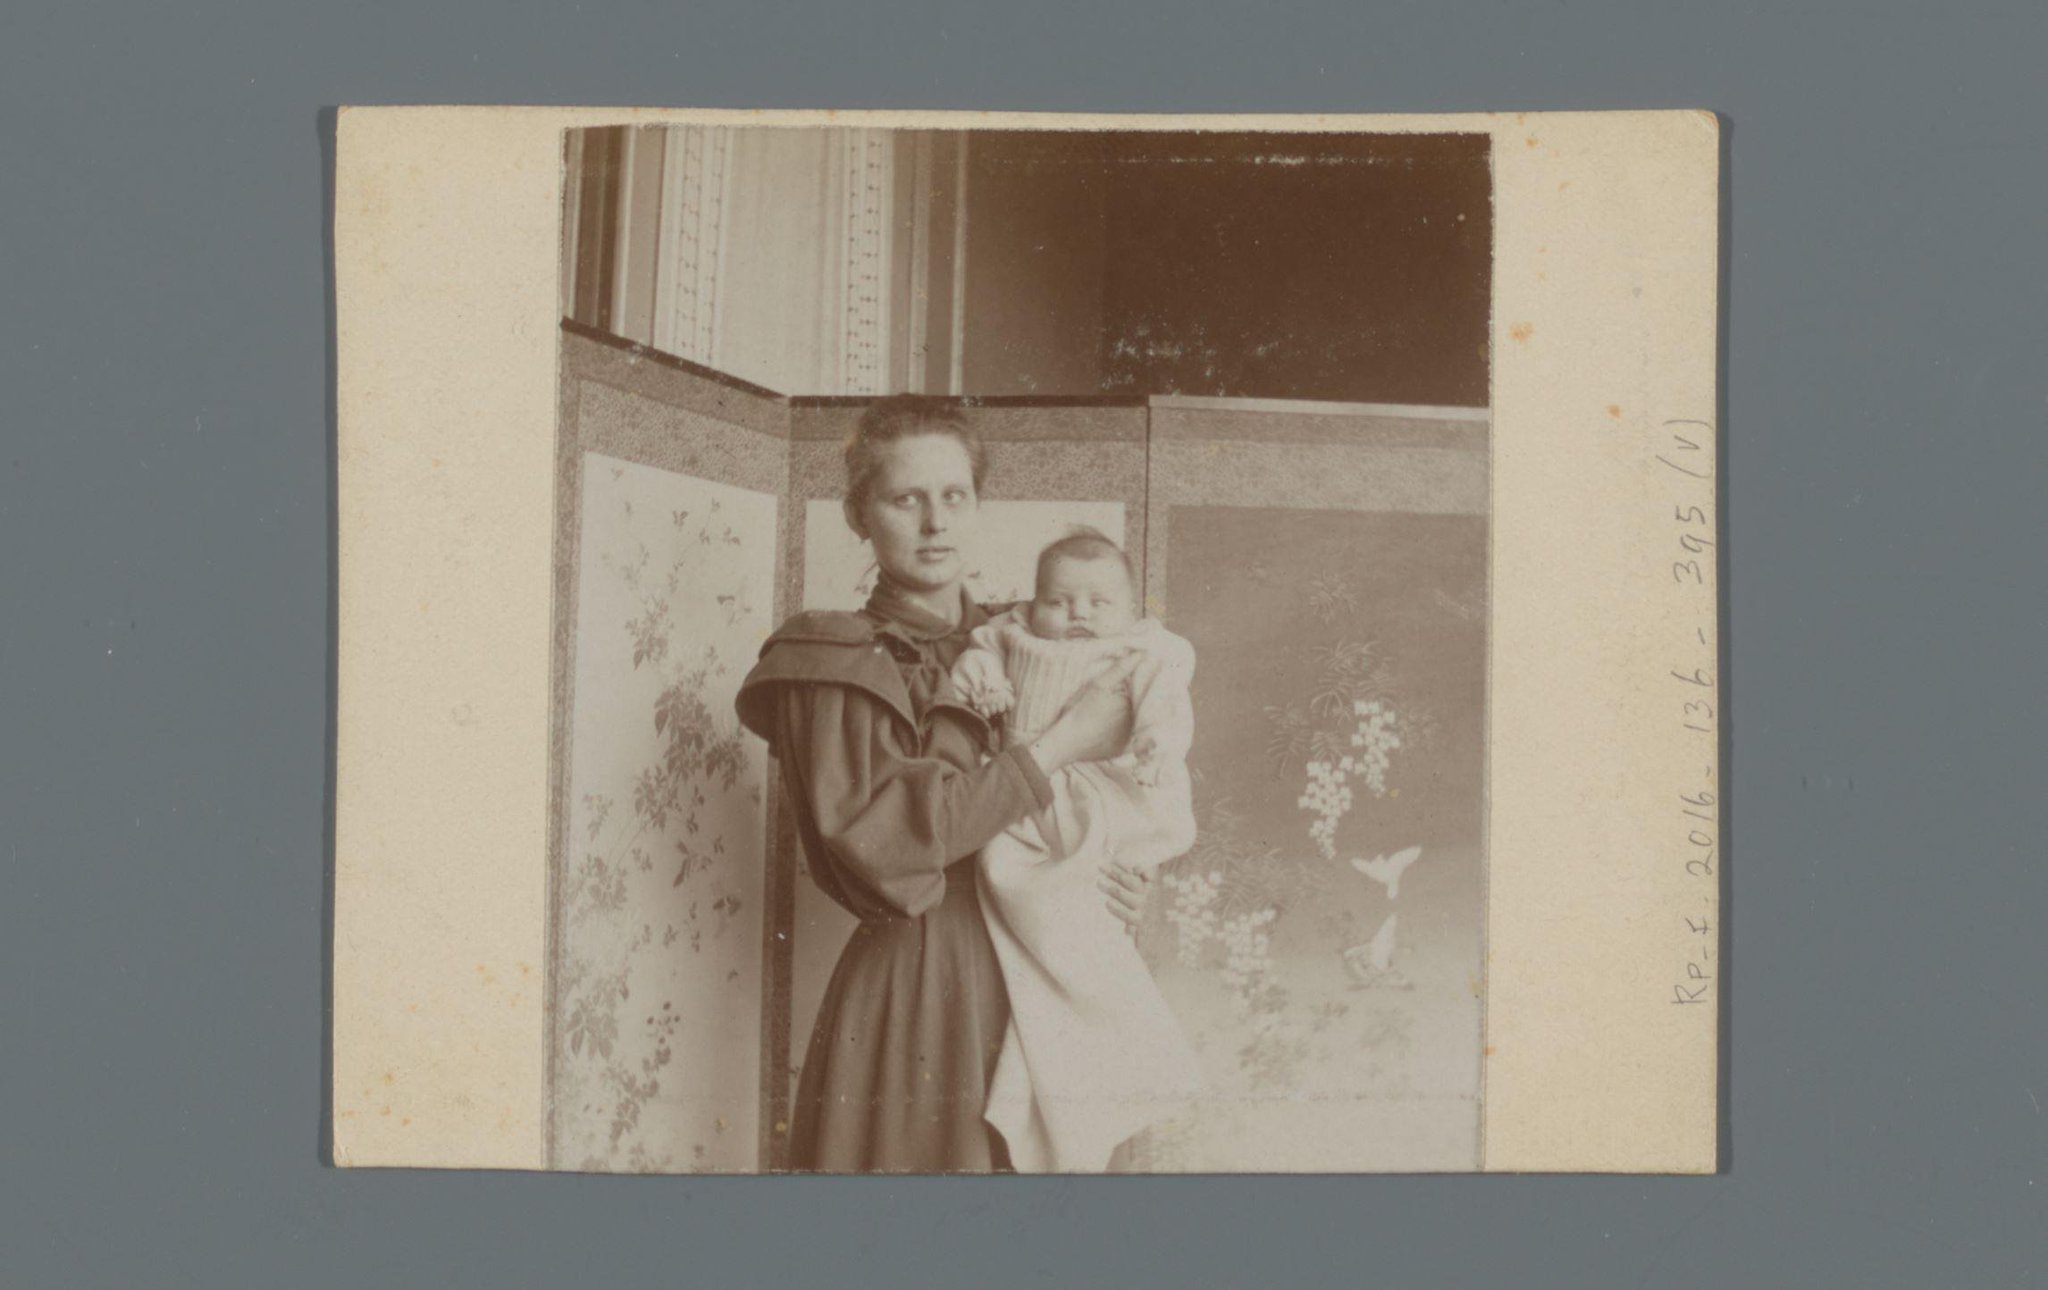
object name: photograph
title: Portret van onbekende vrouw met baby voor kamerscherm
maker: hendrik herman van den berg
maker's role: amateurfotograaf, jurist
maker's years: 1875-1944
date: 1890-1894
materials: cardboard, photographic support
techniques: collodion silver print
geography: amsterdam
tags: rotterdam, norbertus petrus van den berg (1831-1917)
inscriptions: inscription: ‘1896 Baarn op de bok Herman Stelling; vader; oom Wim; tante Jeanne; grootvader N.P.; tante Leo; oom Karel, moeder’